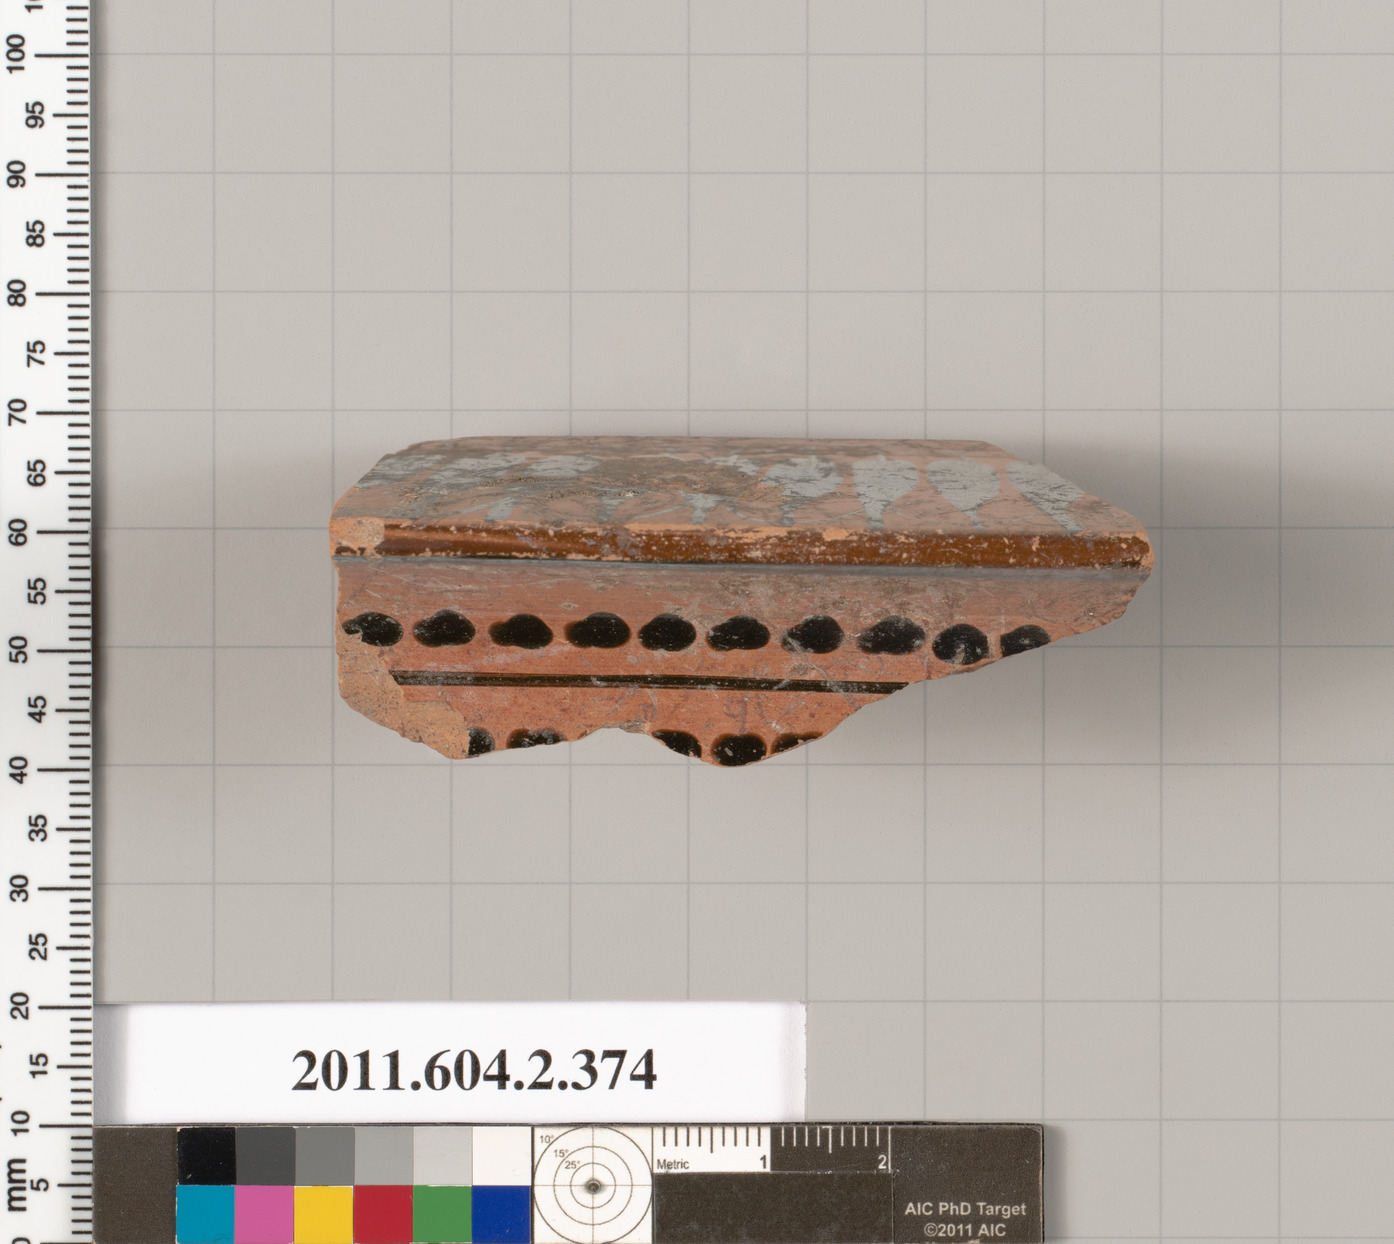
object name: column krater fragment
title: Terracotta fragment of a column-krater (bowl for mixing wine and water)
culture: greek, attic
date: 460-440 BCE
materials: terracotta